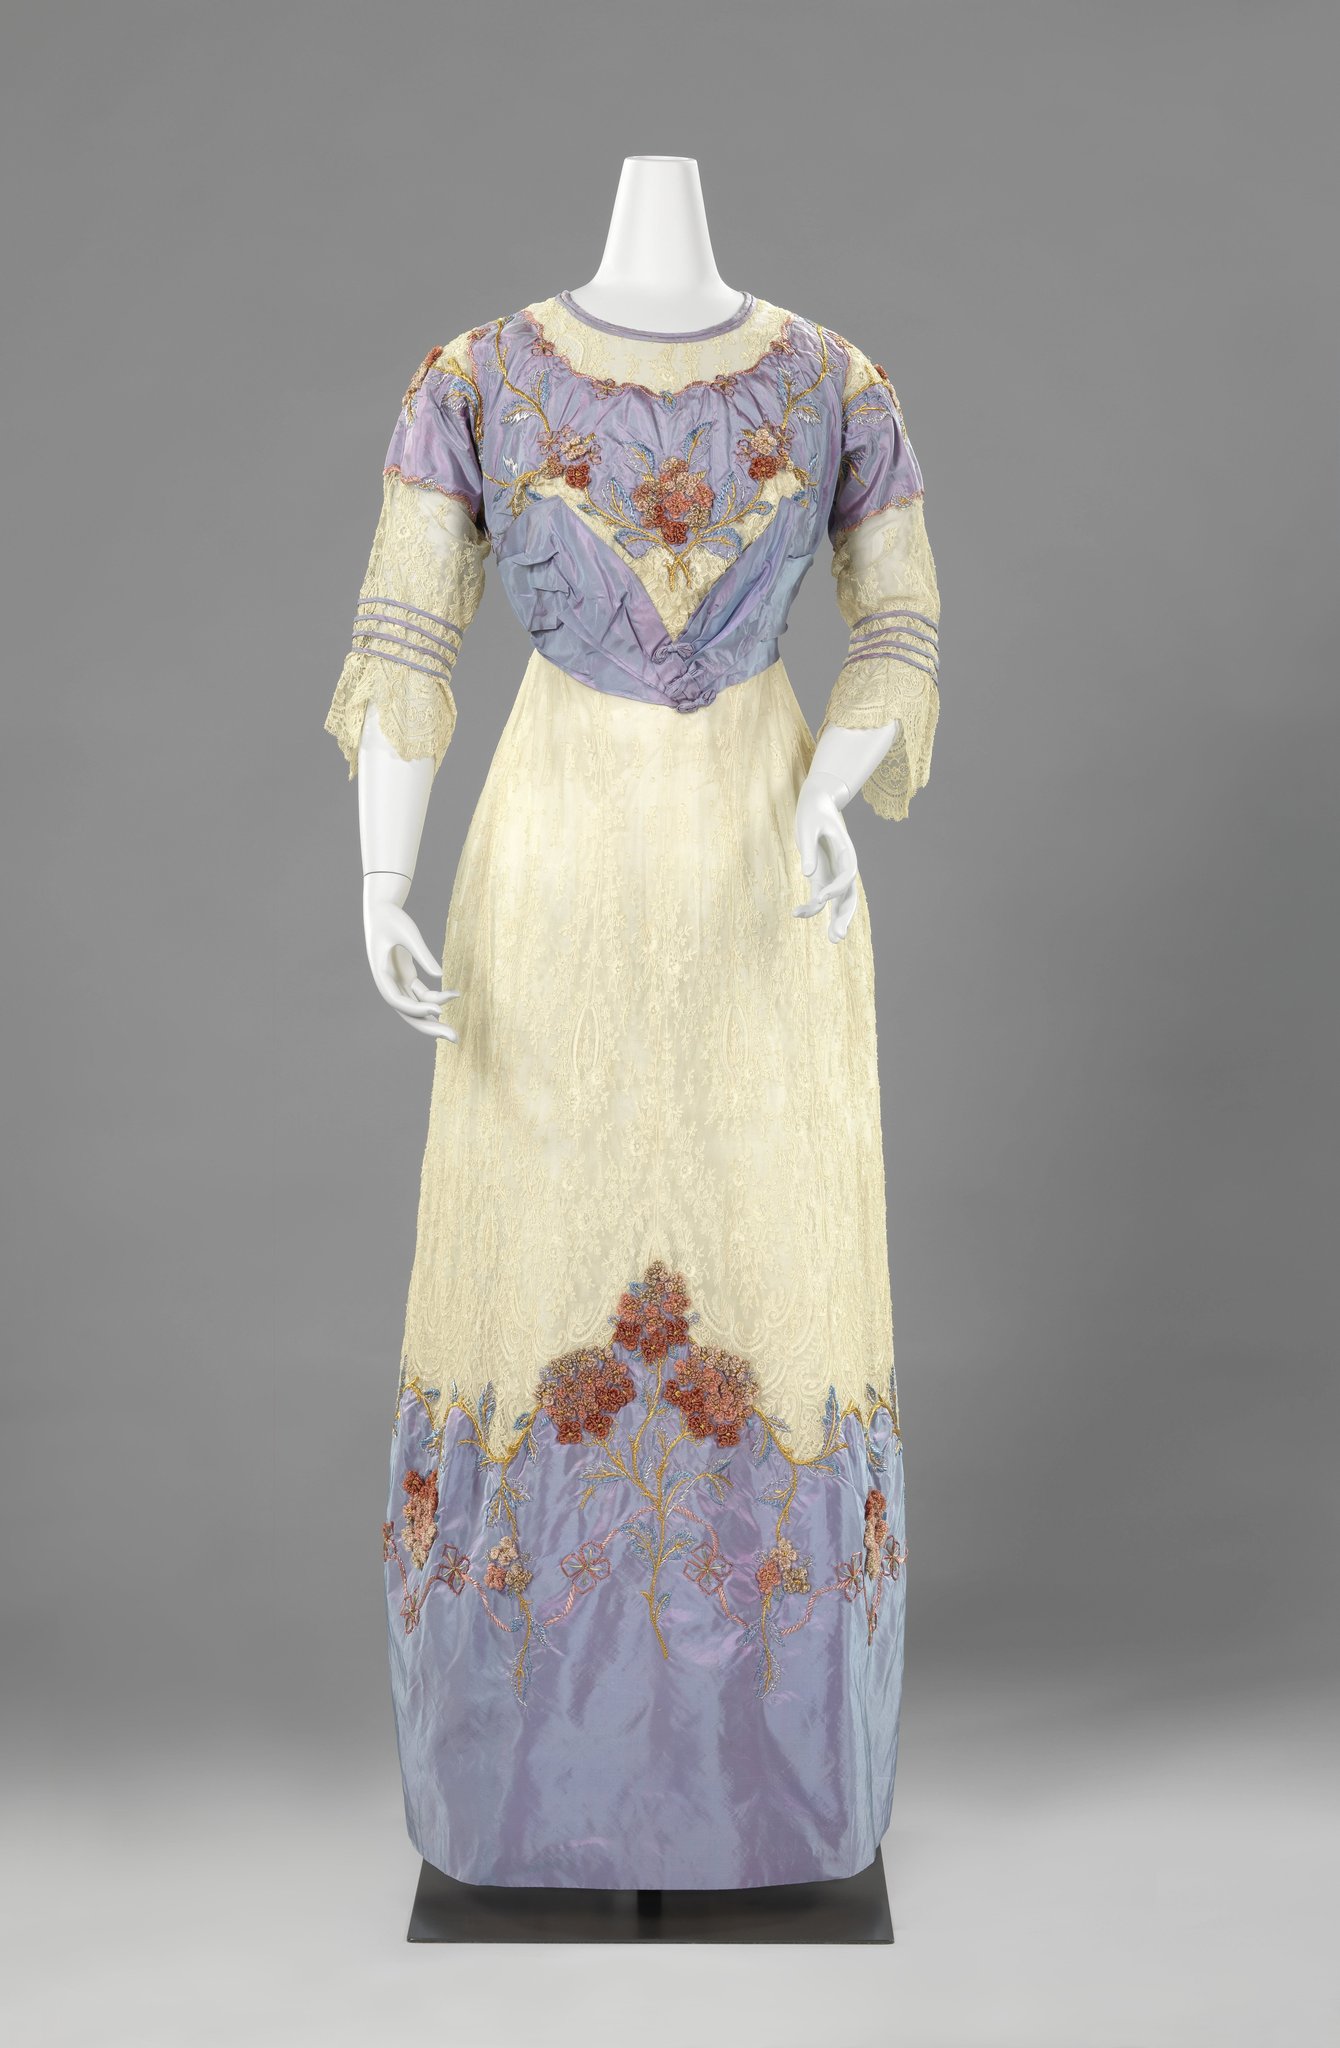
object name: foureau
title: Gown (fourreau)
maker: Anonymous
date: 1910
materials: cotton, metal thread, silk, textile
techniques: embroidered, weave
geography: netherlands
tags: amsterdam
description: Thanks to the designer Paul Poiret tubular dresses became fashionable from 1906. In French this slender silhouette is called fourreau, or sheath. The purple taffeta divides this dress into three parts and creates the illusion of short sleeves. All of this is typical for 1910, as are the voluminously rendered flowers. They are not embroidered flatly, but fashioned of tiny loops and knots.